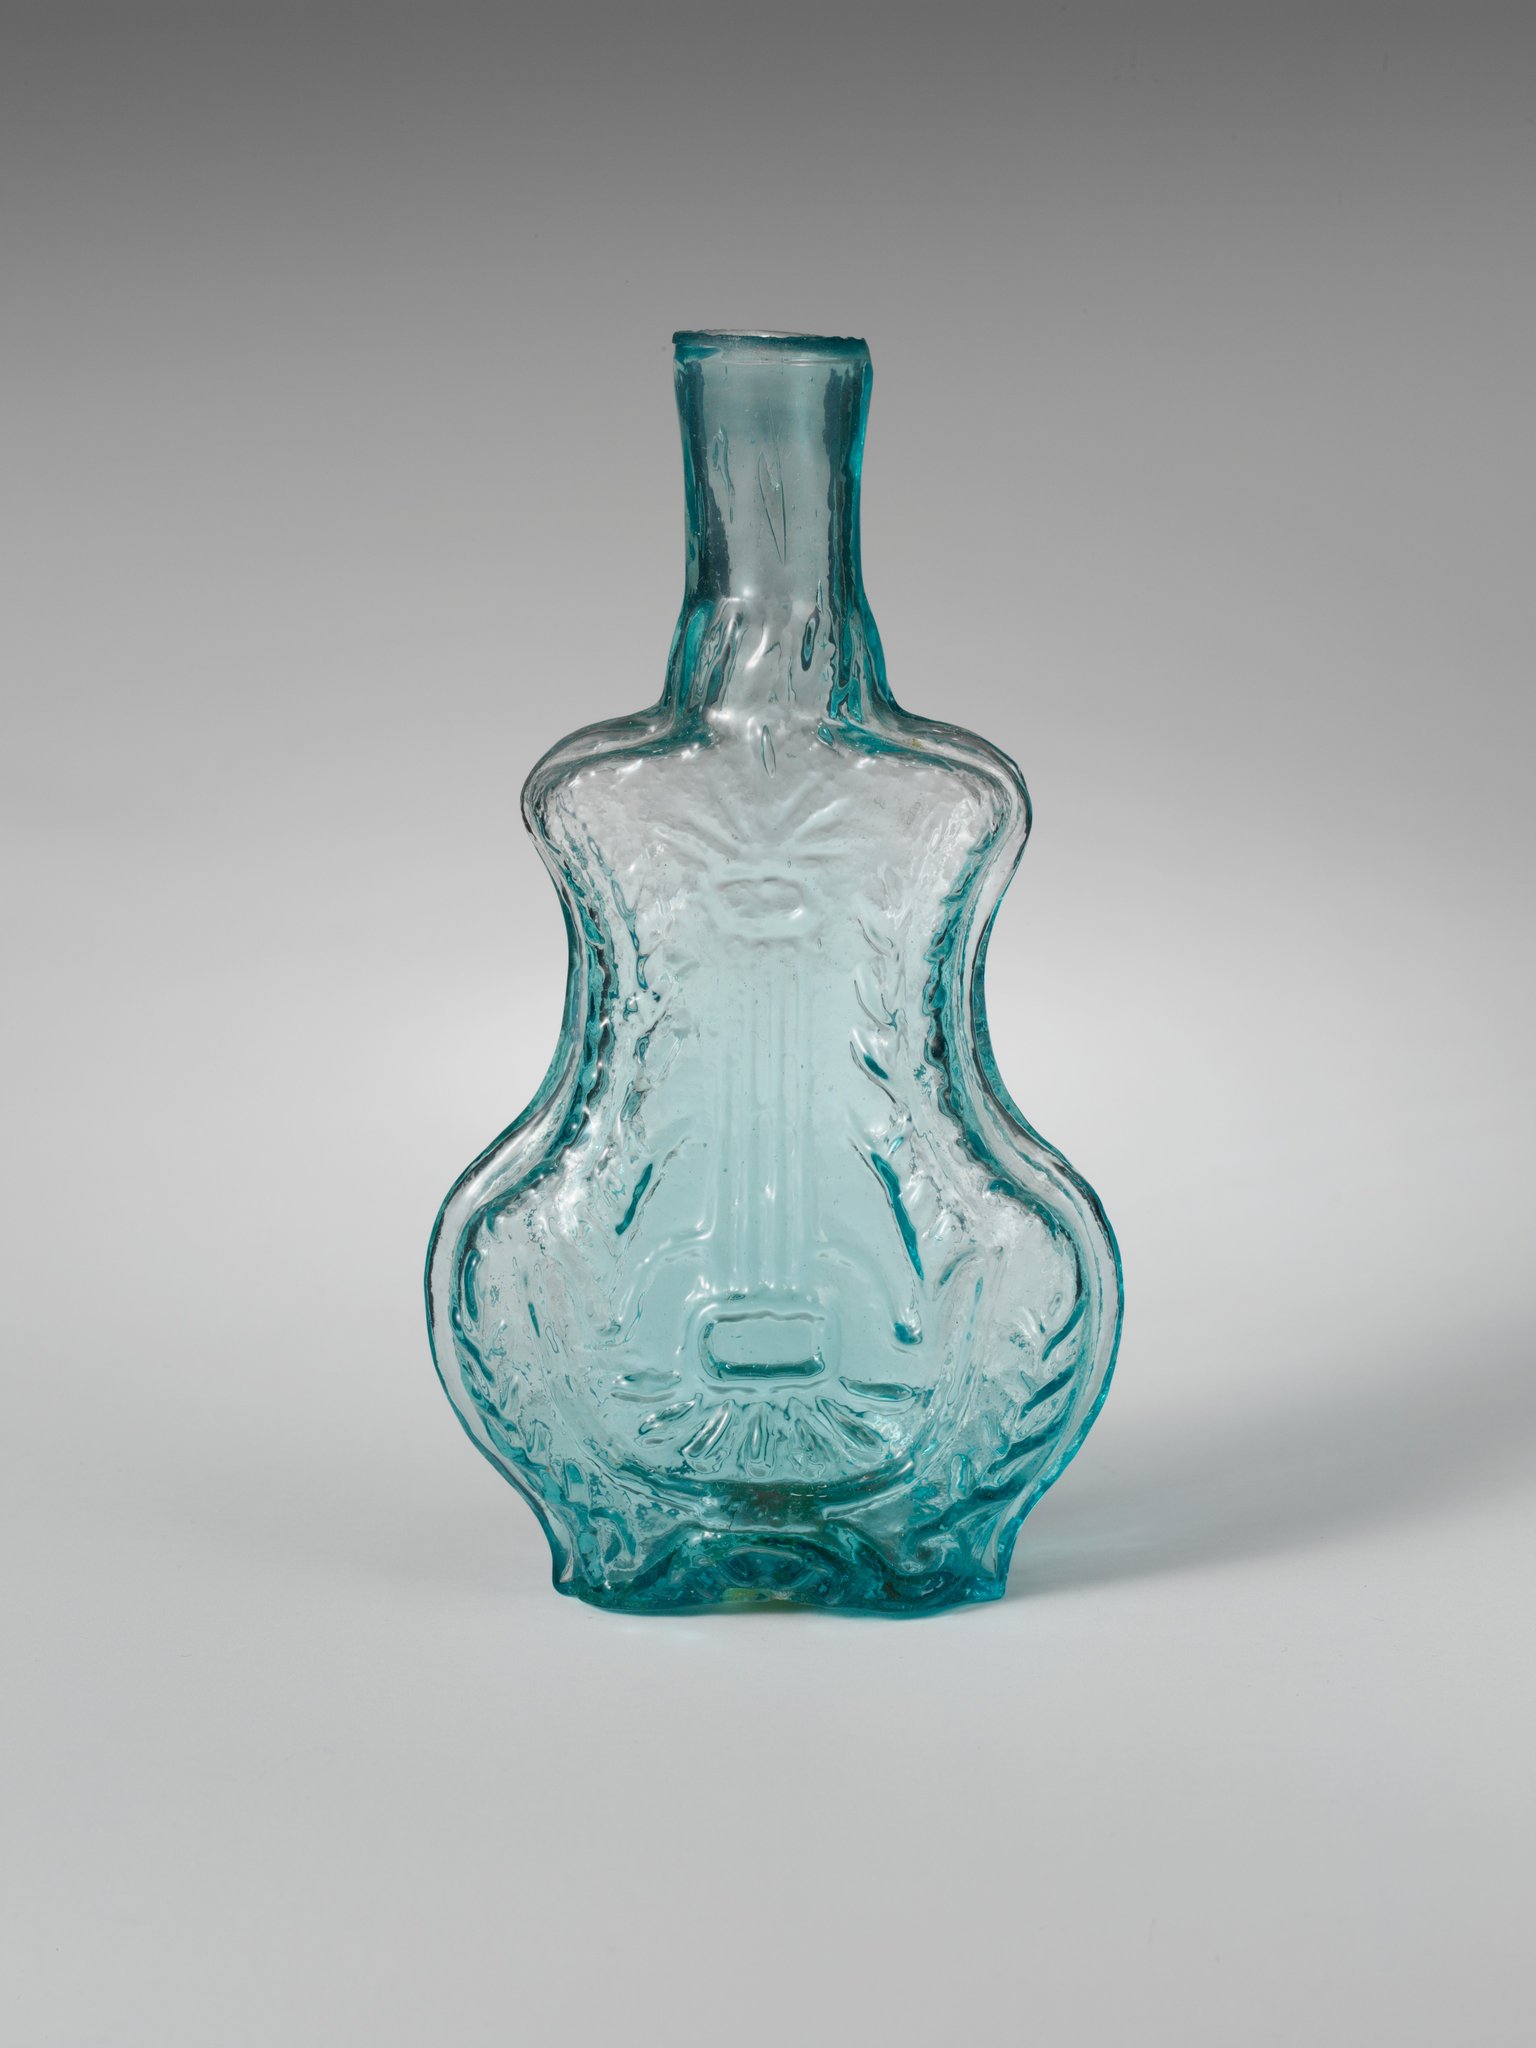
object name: perfume bottle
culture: american or french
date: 1840-1850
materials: gemstone, glass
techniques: glassblowing, molding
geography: france